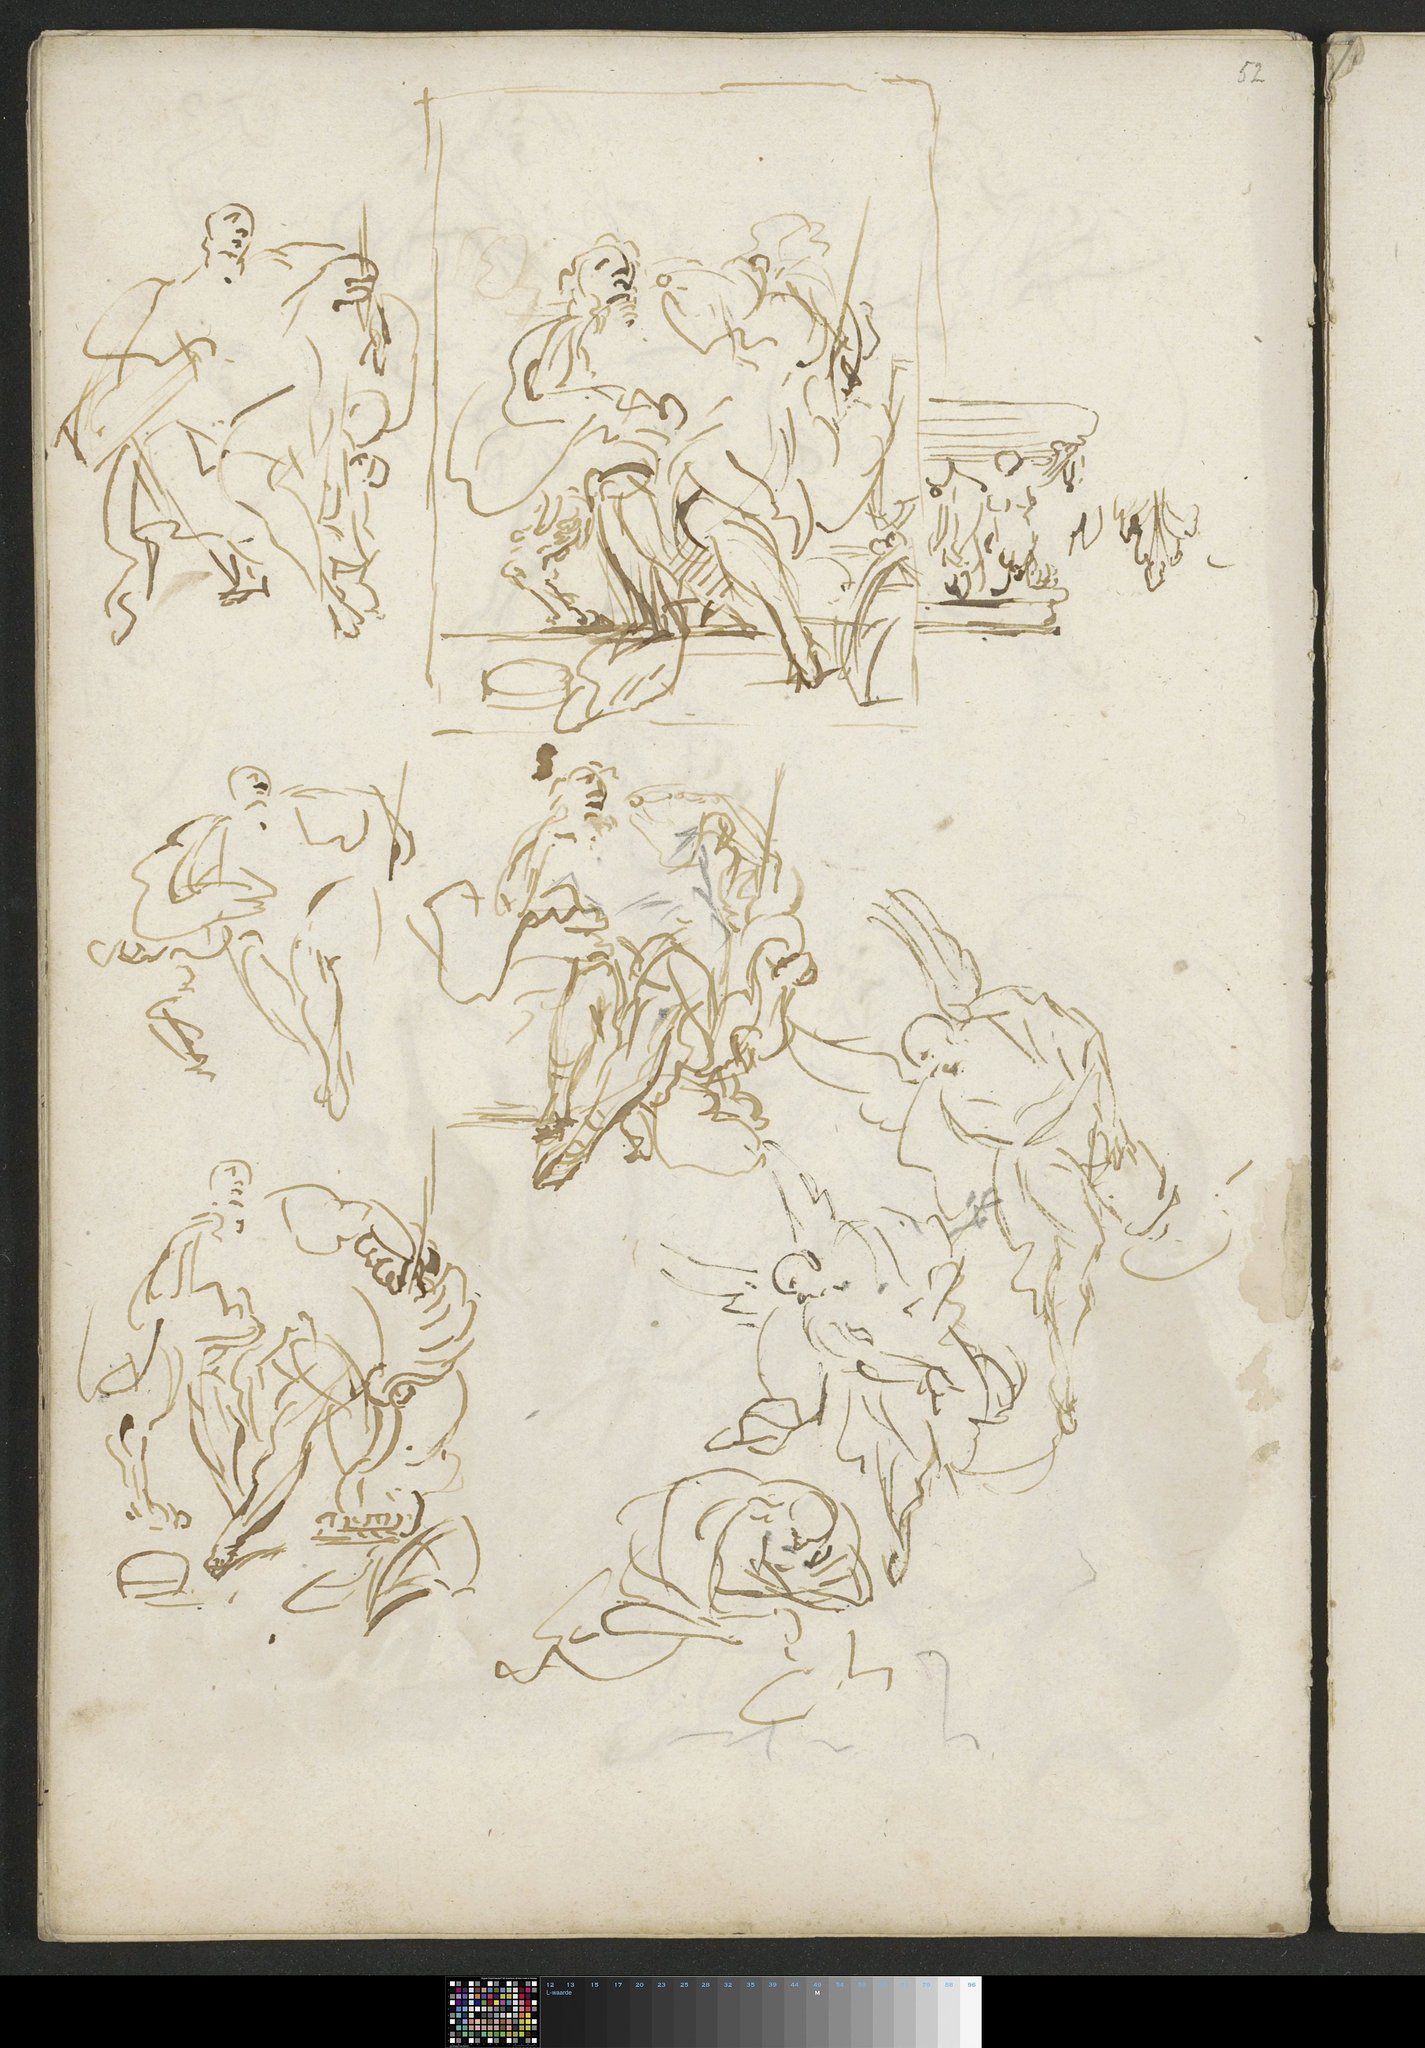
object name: sketchbook leaf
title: Studieblad met zittende en gevleugelde mannen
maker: Anonymous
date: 1650-1799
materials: ink, paper, pencil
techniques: pen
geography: italy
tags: sitting figure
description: Bladzijde 52 uit een schetsboek met 72 bladzijden.